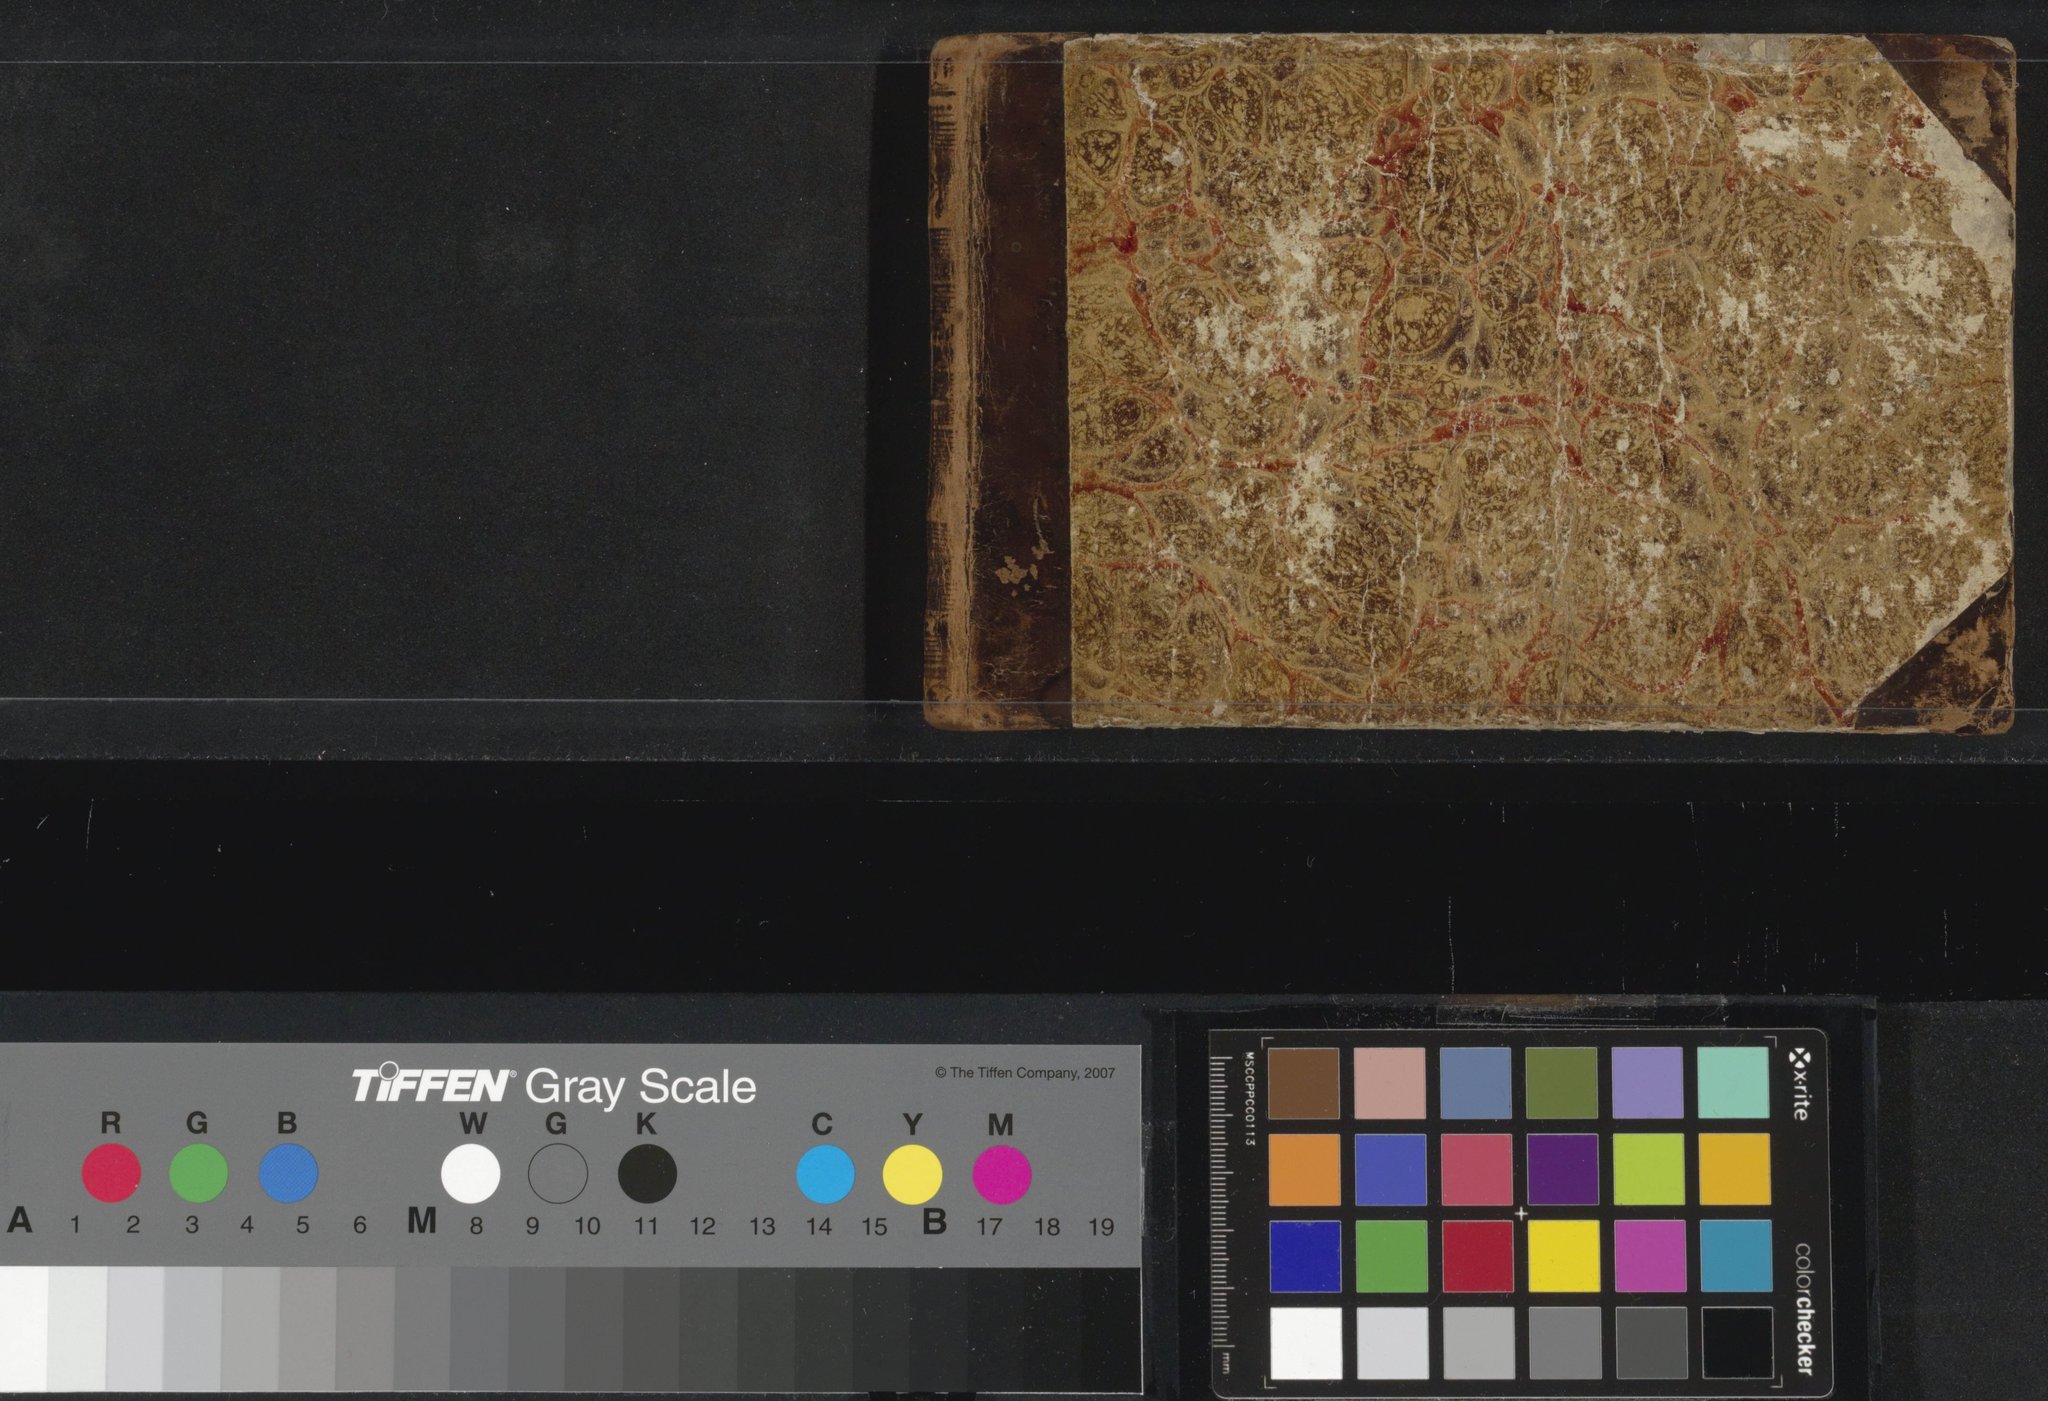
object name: sketchbook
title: Schetsboek met 60 bladen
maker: willem hendrik schmidt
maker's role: draughtsman, painter, print maker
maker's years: 1809-1849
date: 1819-1849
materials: chalk, ink, leather, paper, pencil, watercolor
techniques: brush, pen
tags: trees, historical costume, interior of the house, architecture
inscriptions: collector's mark: Lugt 2228a, signature and address: ‘W.H. Schmidt./ hoogstraat Wijk J. 390./ Rotterdam/ J W. Schmidt/ hoogstraat wijk J 390/ Rotterdam’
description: Schetsboek bestaande uit 60 bladen met figuren, historisch kostuum, architectuur, genretaferelen, bomen en voorstudies voor of kopieën naar schilderijen.